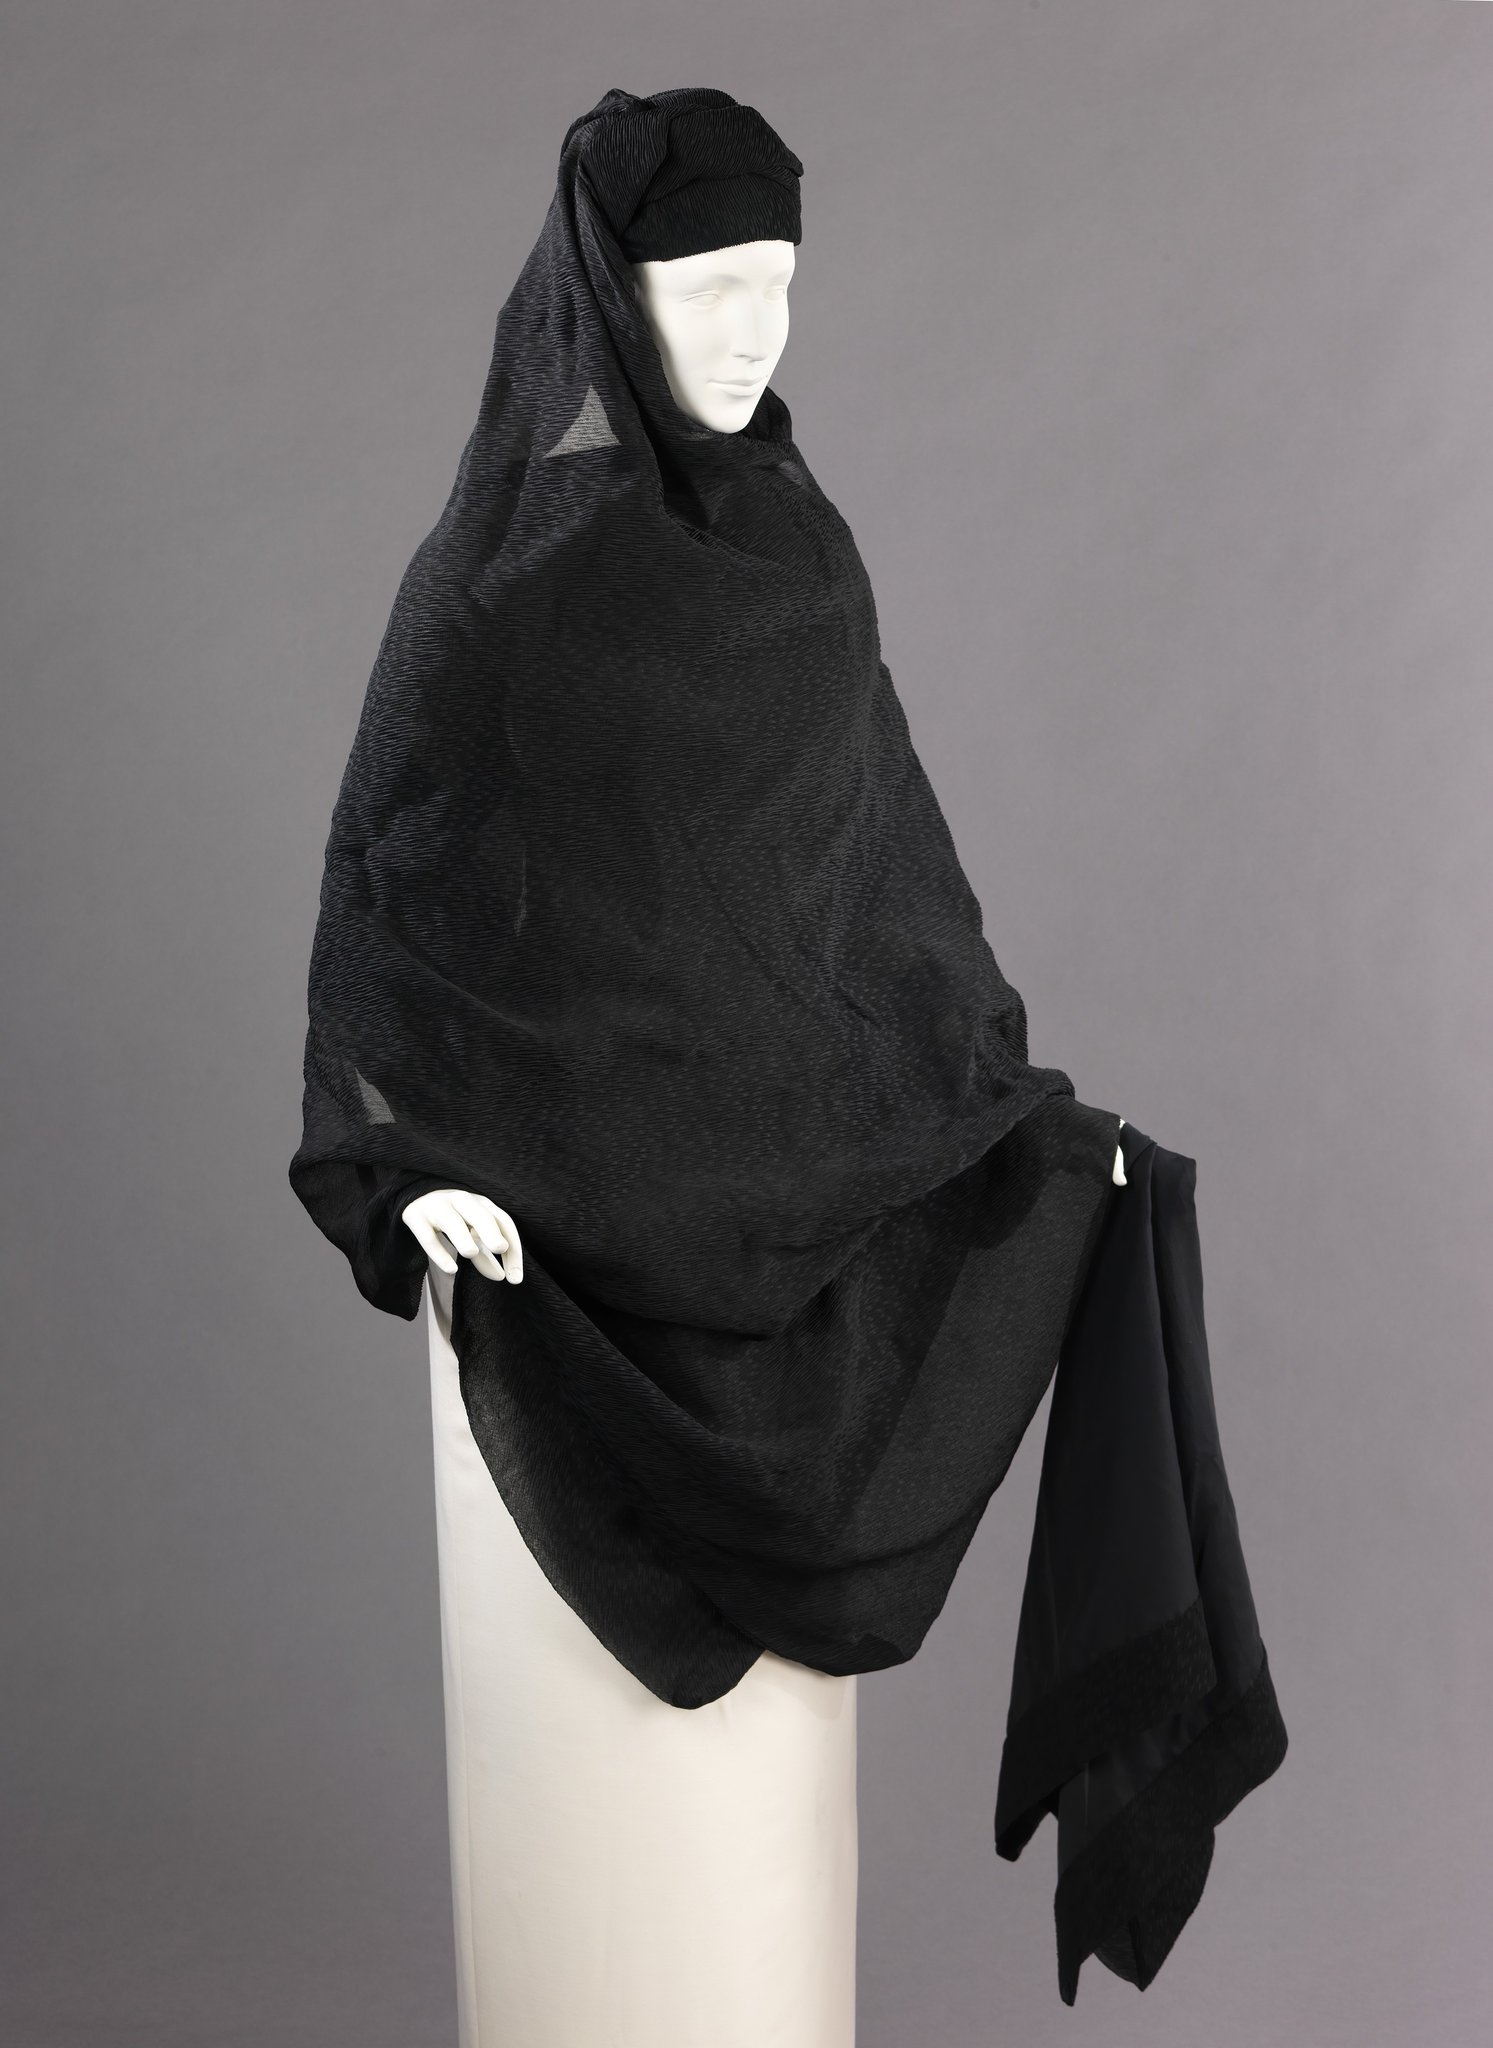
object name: mourning accessory set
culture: american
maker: wanamaker's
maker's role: department store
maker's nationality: american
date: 1895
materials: silk